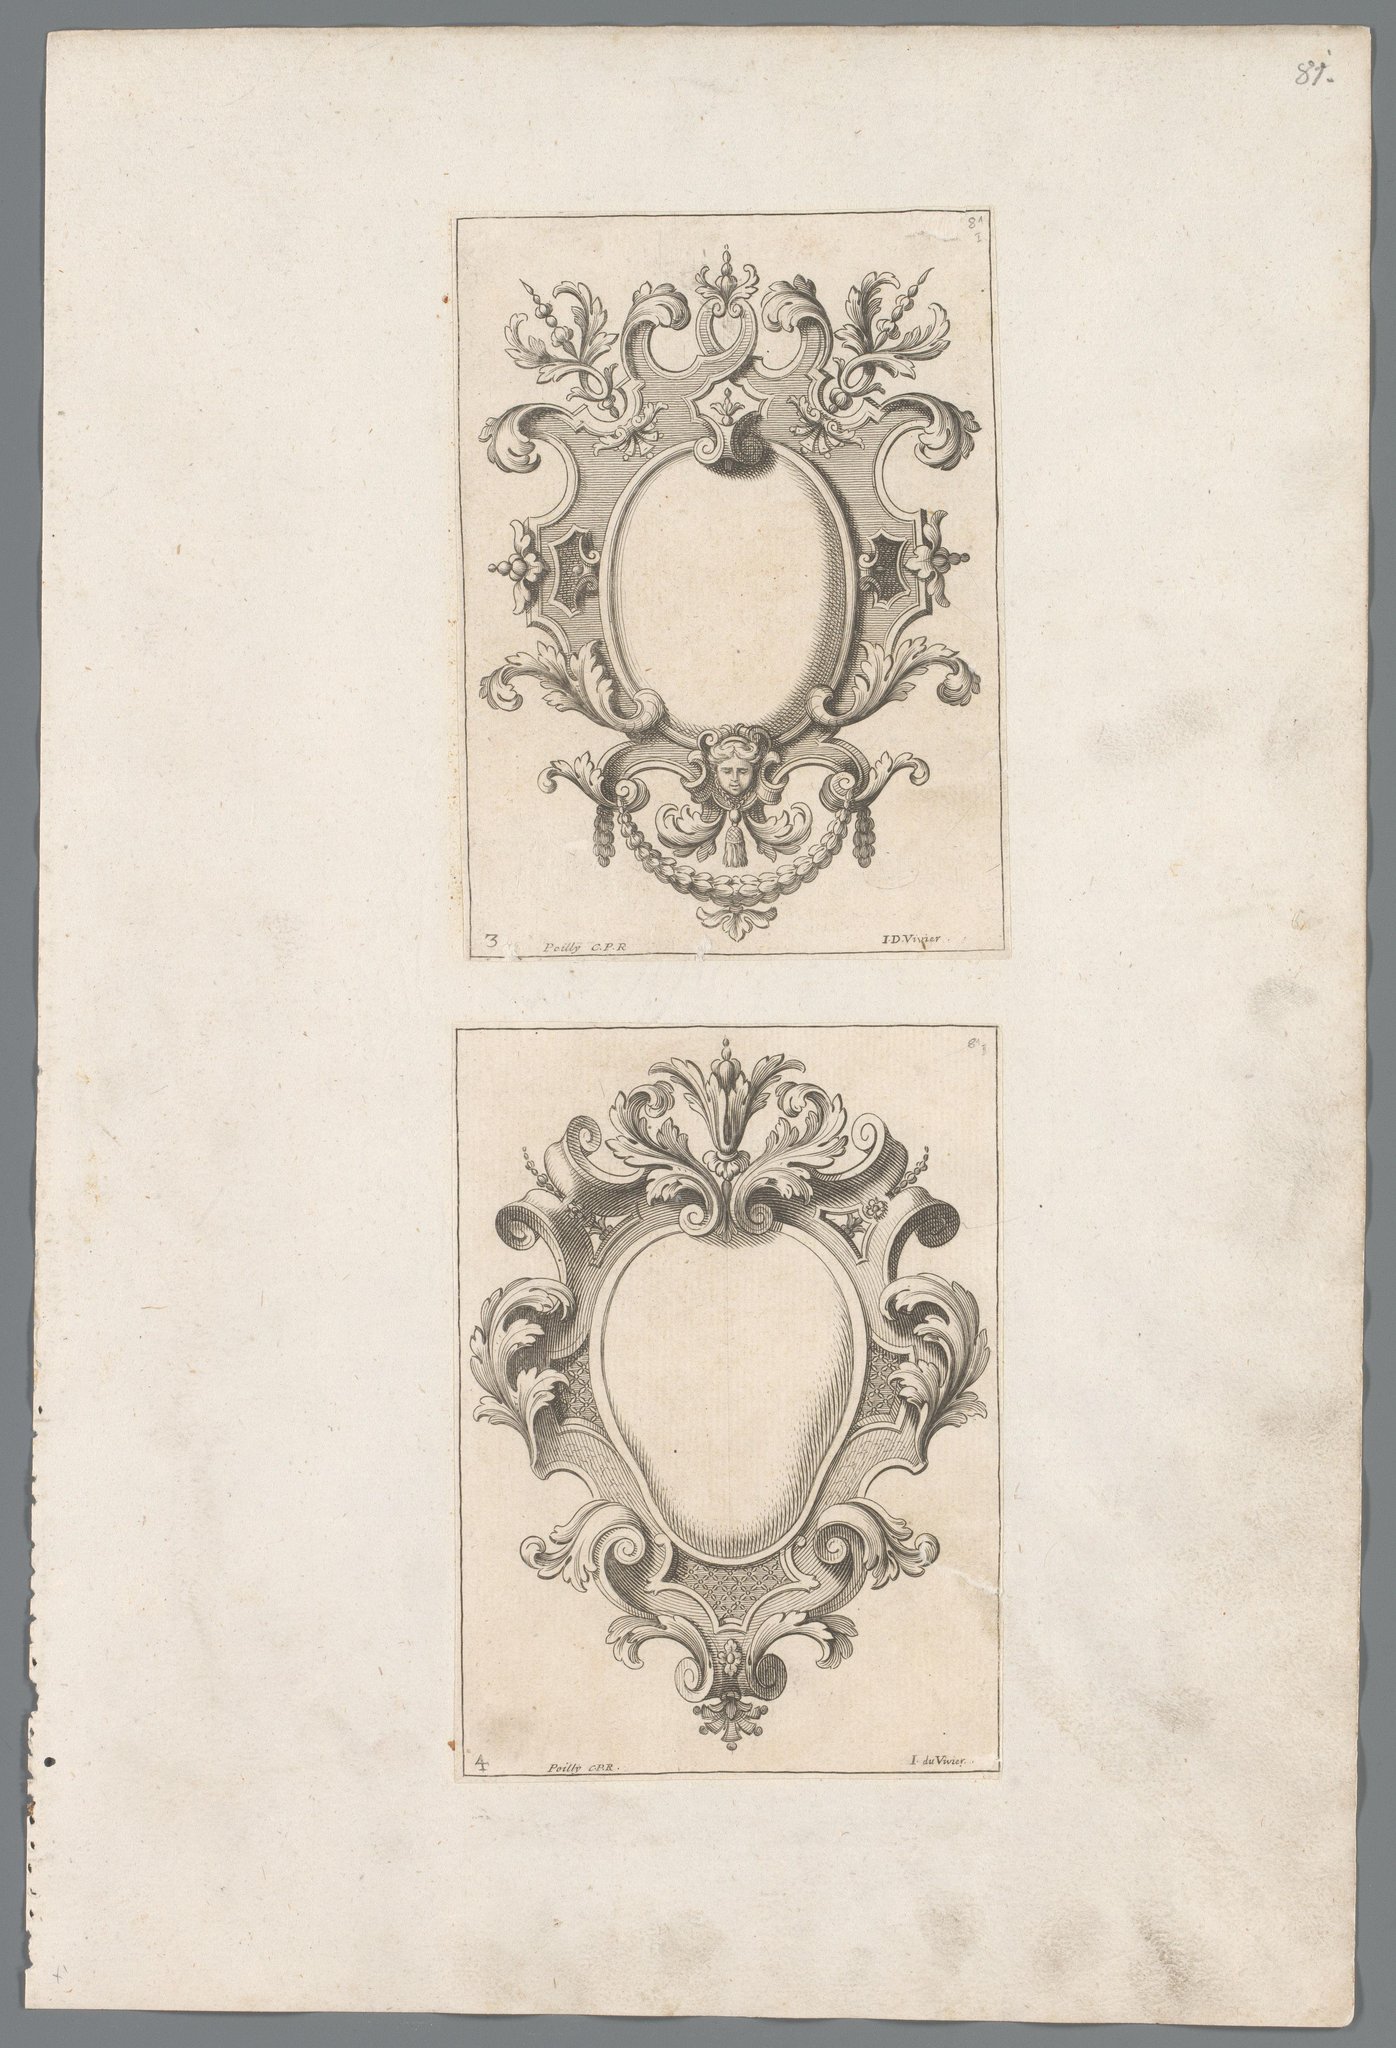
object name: ornament print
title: Nieuwe cartouches voor wapenschilden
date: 1712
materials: paper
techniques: engraving, etching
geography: paris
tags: ornament ~ cartouche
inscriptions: collector's mark: Lugt 2228, collector's mark: Lugt 2760